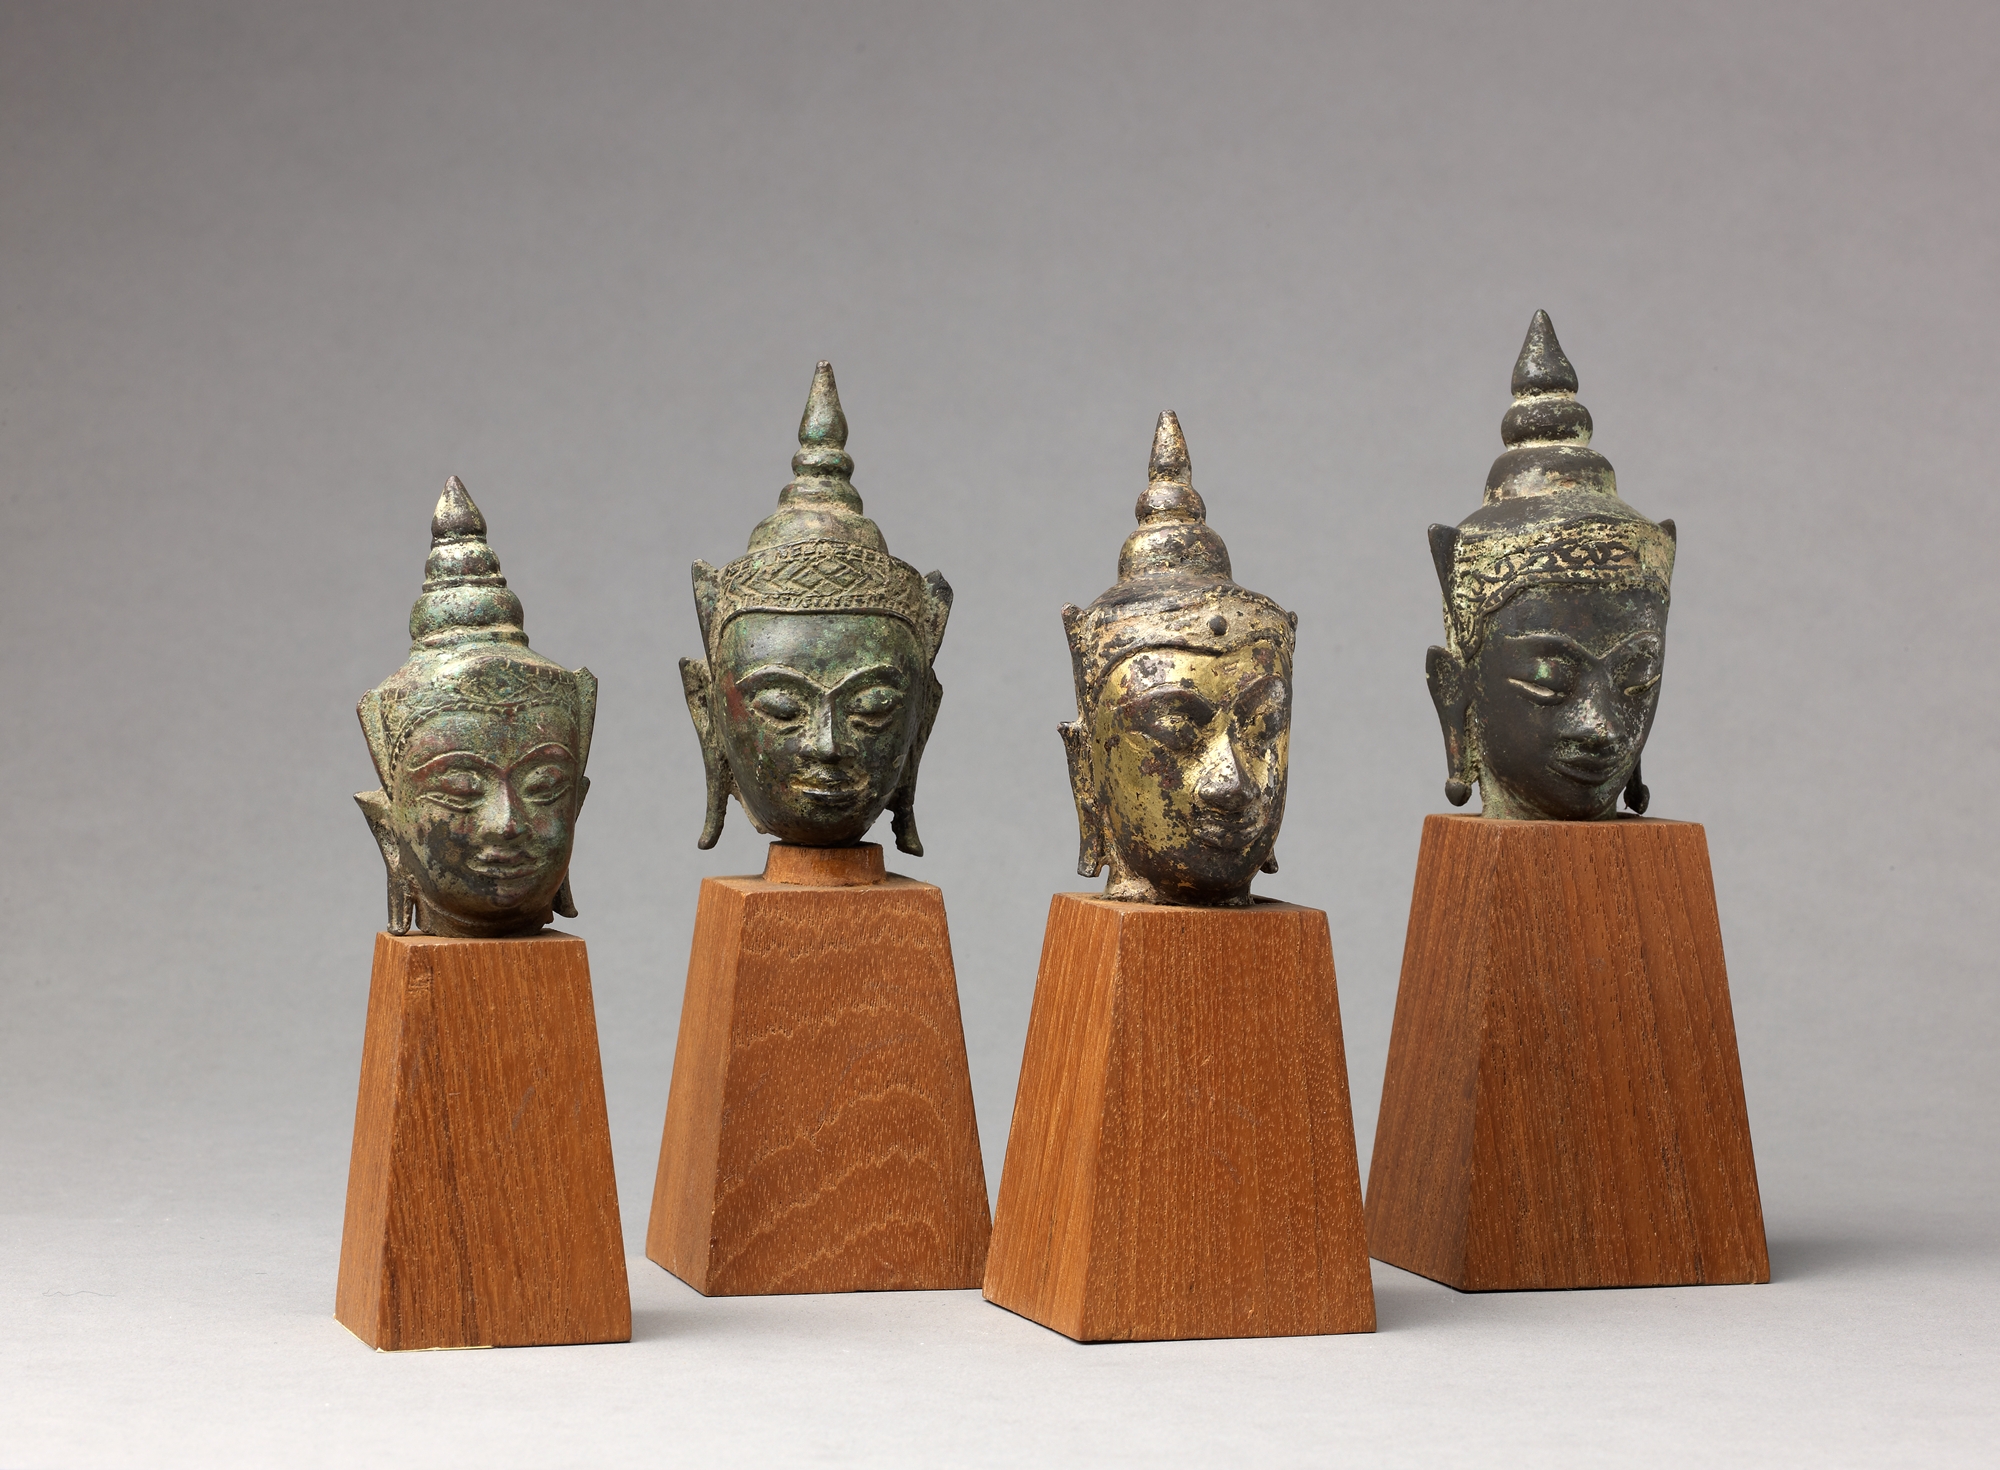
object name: sculpture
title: Head of the Buddha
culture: thai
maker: thai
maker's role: artist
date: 1767-1900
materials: copper alloy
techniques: gilding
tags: heads,buddha